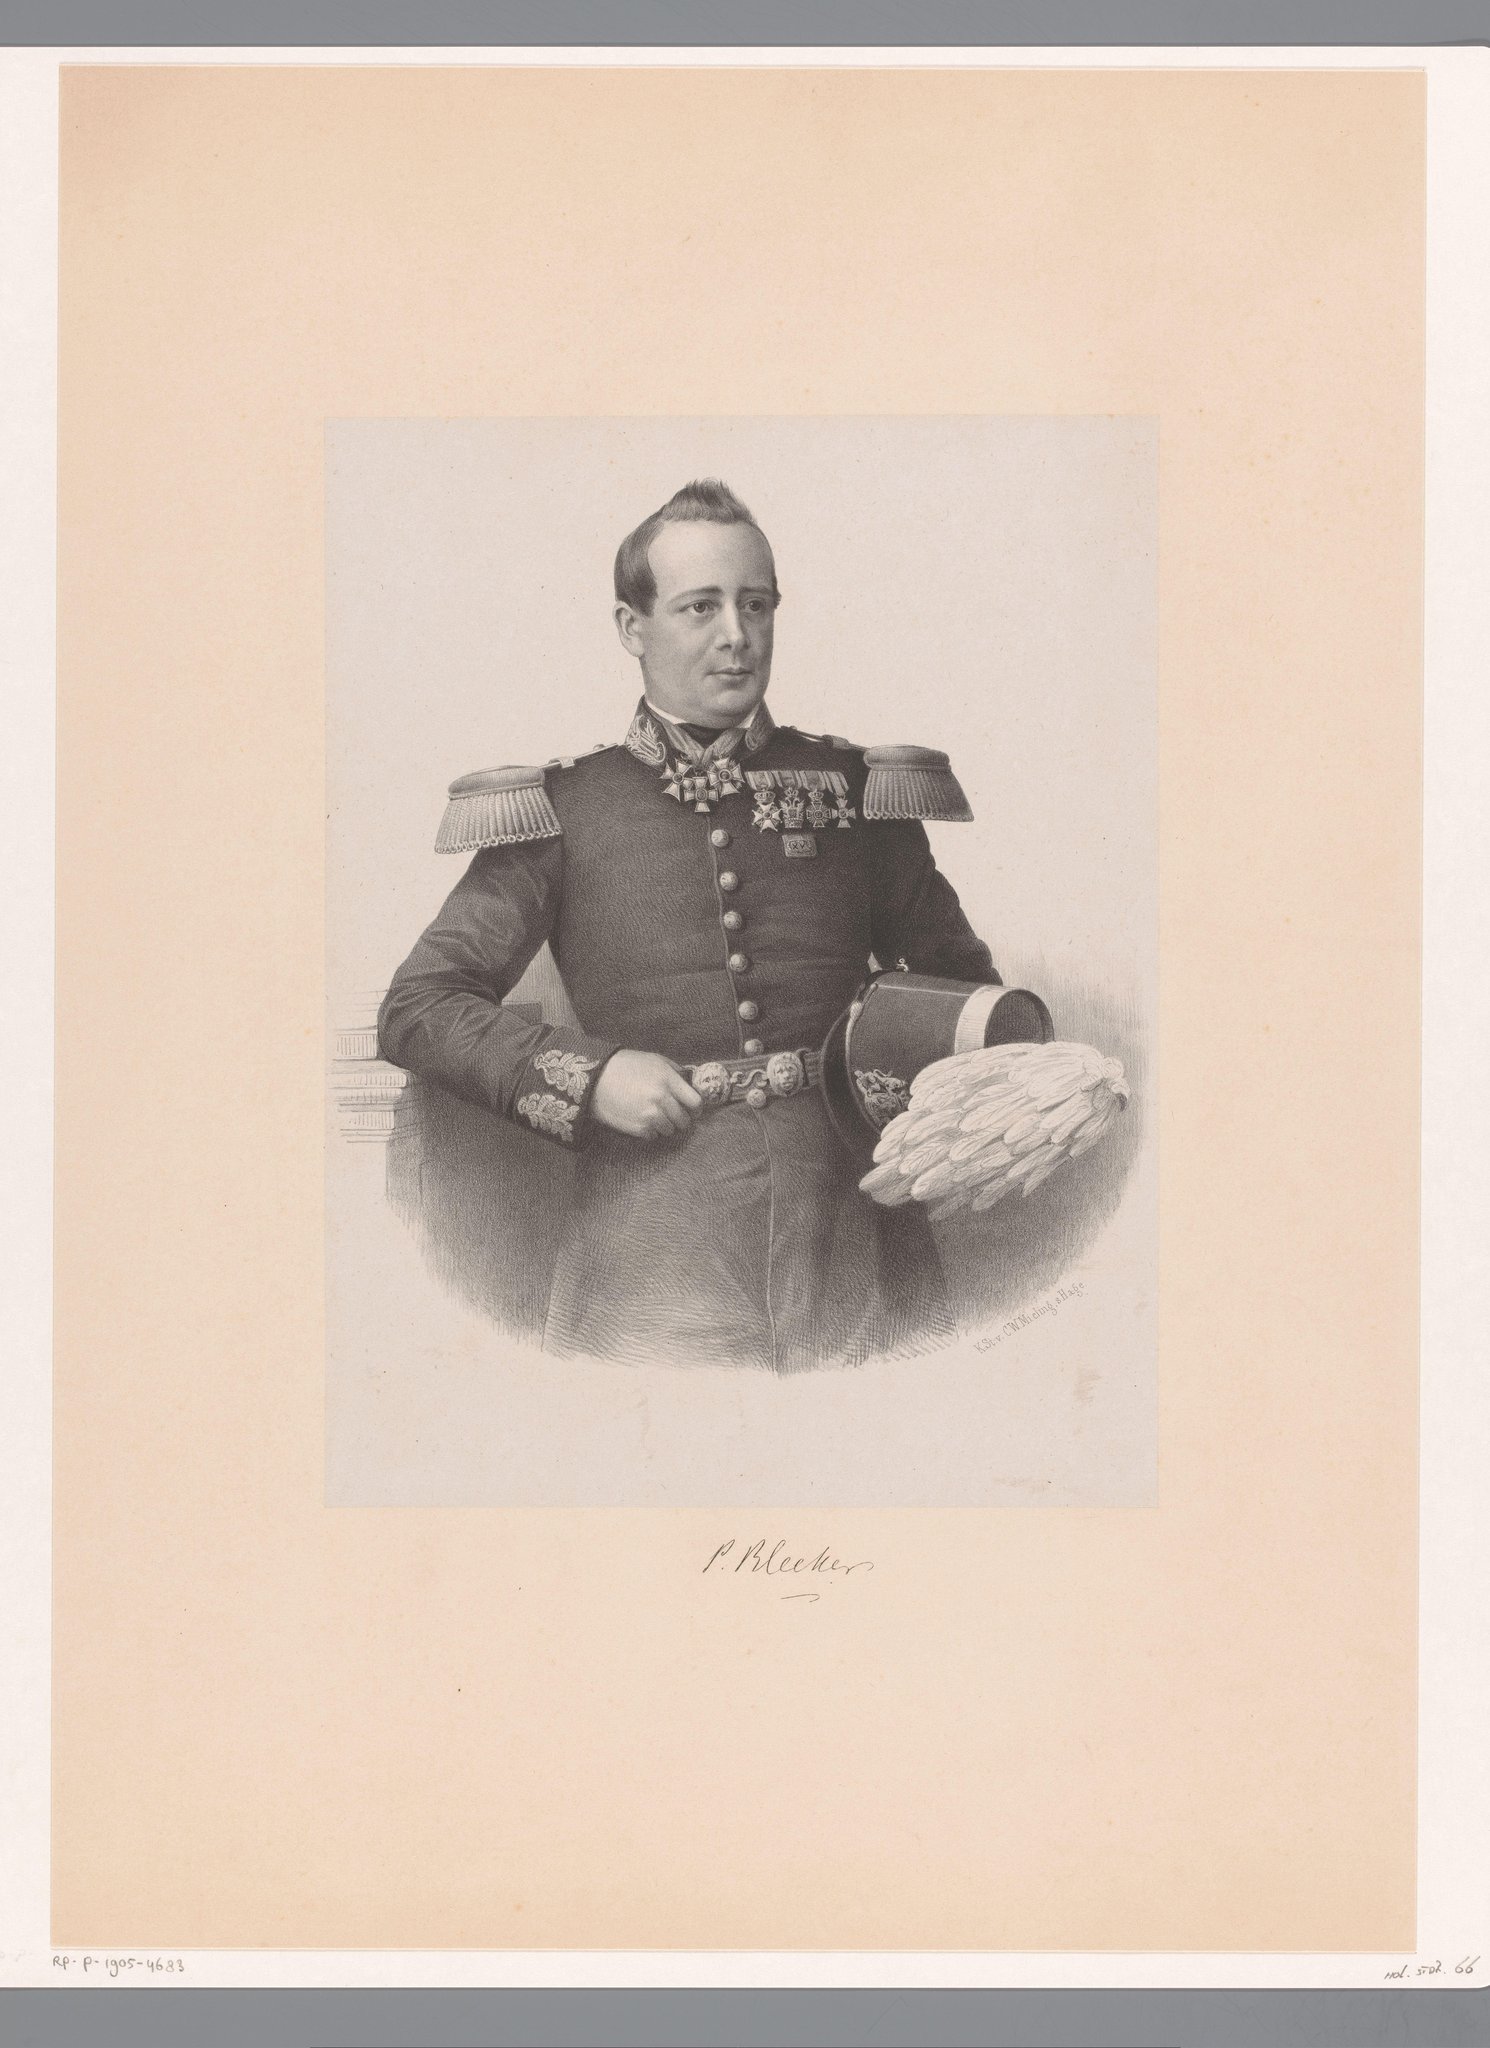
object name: print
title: Portret van Pieter Bleeker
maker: Anonymous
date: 1847-1865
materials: paper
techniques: lithograph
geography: the hague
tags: the hague, knighthood order, historical persons (+ half-length portrait)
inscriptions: collector's mark: Lugt 2228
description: De geportretteerde draagt een militair uniform met epauletten en ordetekens op zijn borst en om zijn hals. Hij draagt zijn hoed met pluim in zijn linkerhand. Onder het portret zijn signatuur.